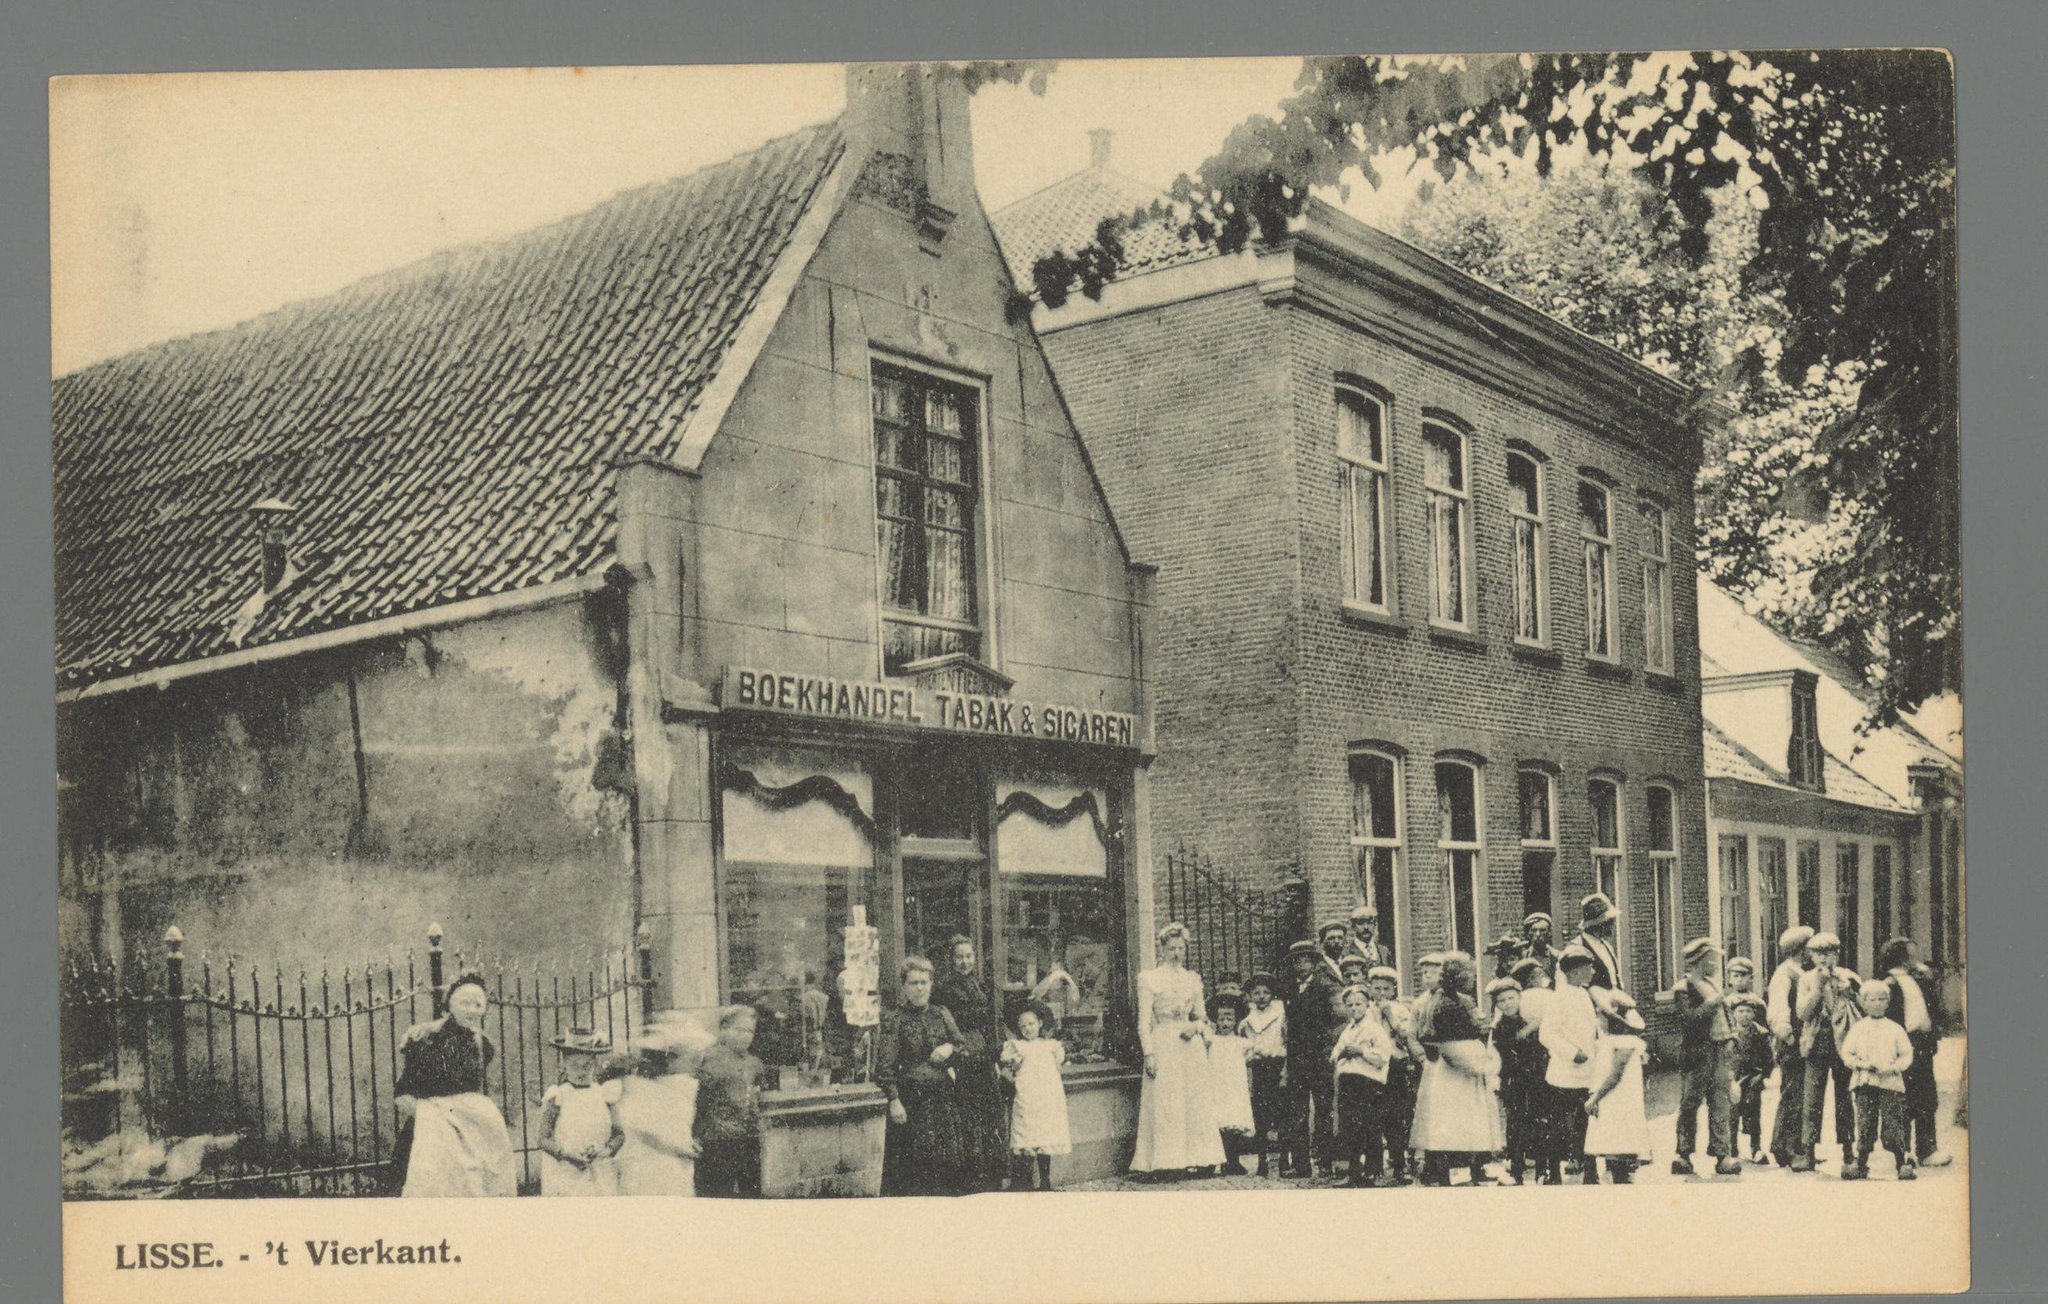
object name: photomechanical print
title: Lisse. - 't Vierkant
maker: Anonymous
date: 1897-1905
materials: cardboard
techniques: photograph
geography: lisse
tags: shop, store